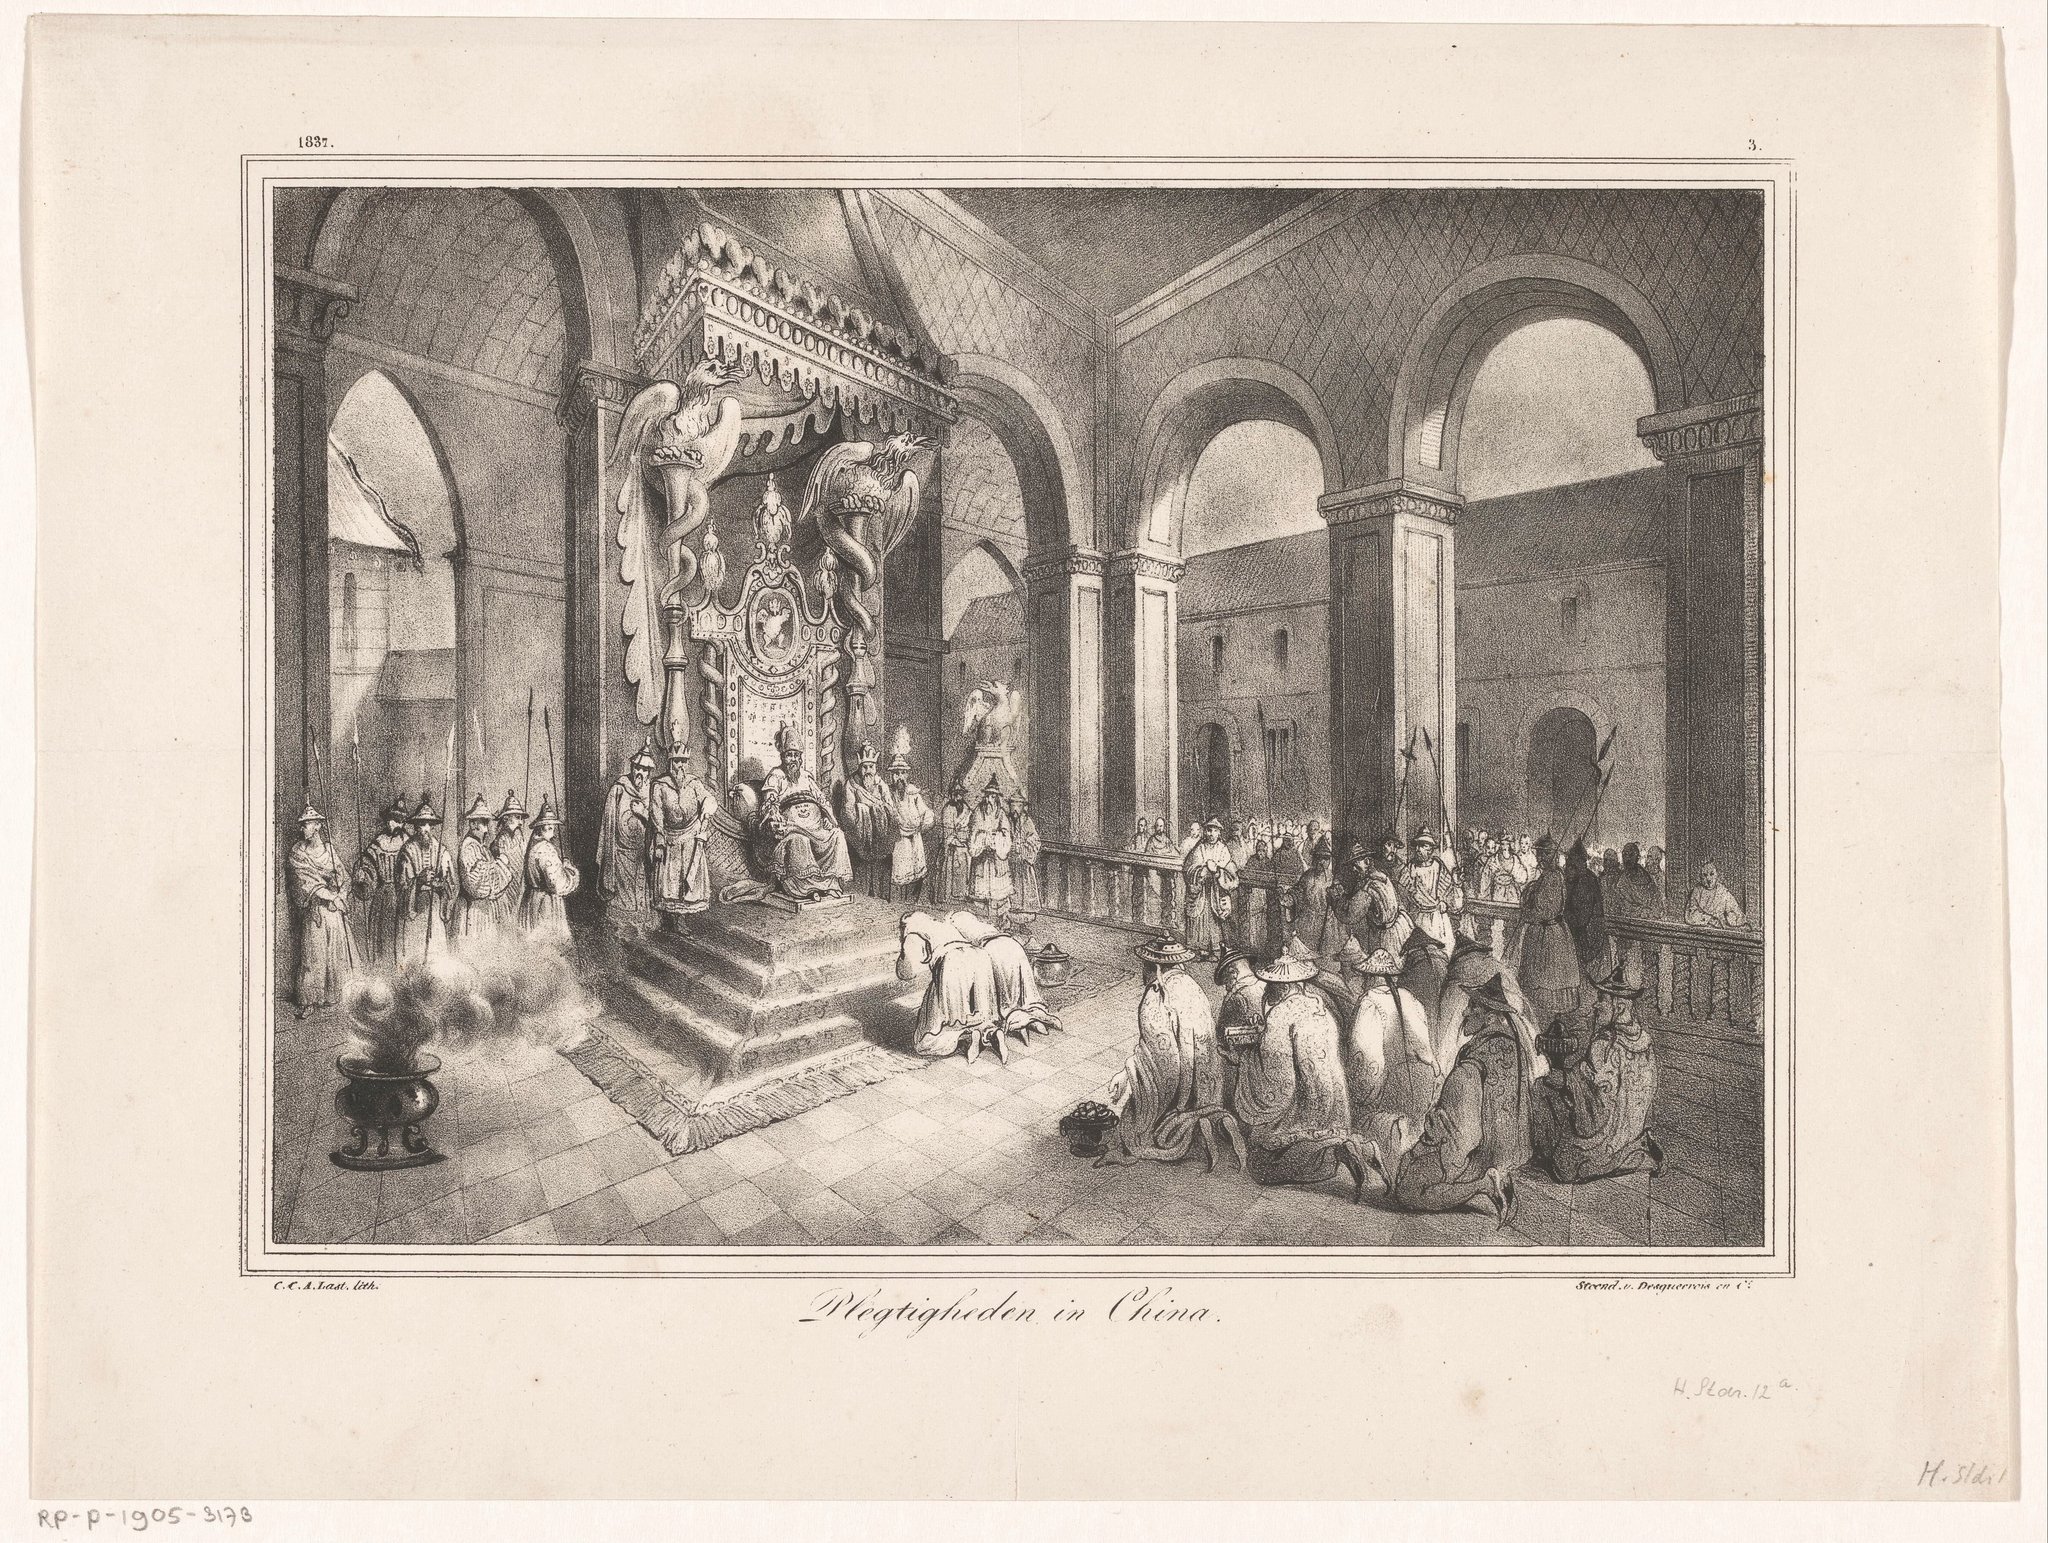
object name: print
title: Plegtigheden in China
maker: carel christiaan antony last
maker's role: print maker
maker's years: 1808-1876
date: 1837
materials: paper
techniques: lithograph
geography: amsterdam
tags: chinese, throne-room, kneeling before a ruler, bringing gifts; exchanging gifts, china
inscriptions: collector's mark: Lugt 2228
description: Een groep Chinese onderdanen zit geknield en voorover gebogen voor een machthebber, gezeten op een troon. Links en rechts soldaten. De onderdanen hebben geschenken bij zich. Genummerd rechtsboven: 3.